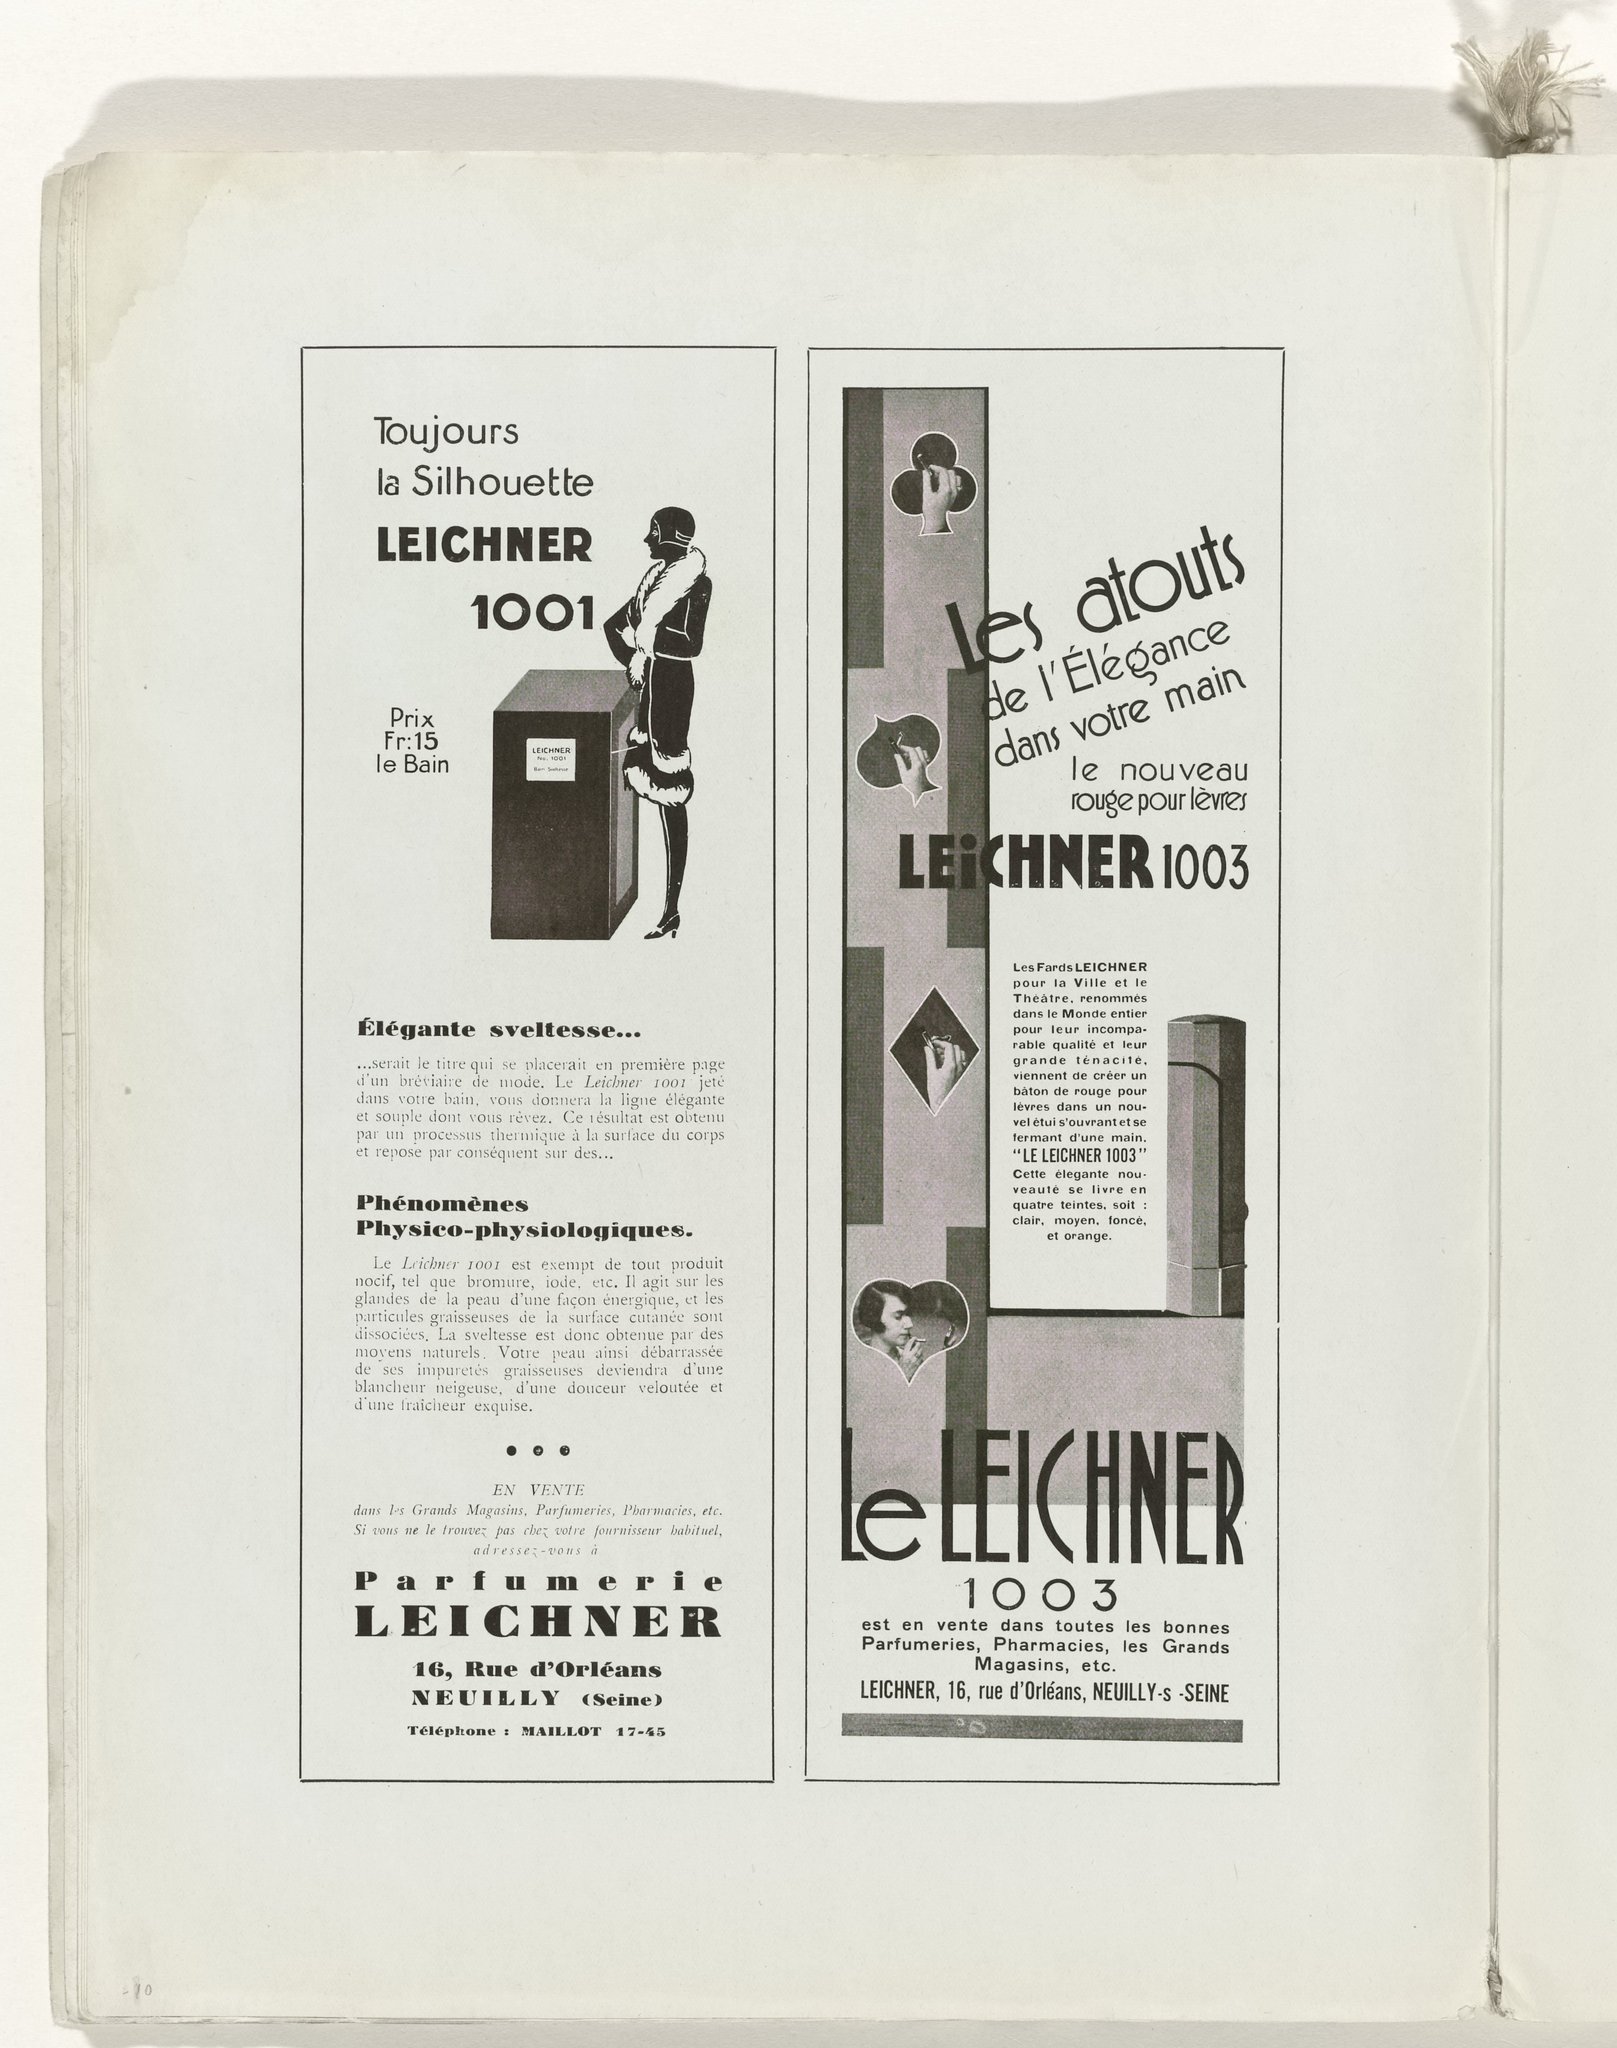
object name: fashion print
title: Art - Goût - Beauté, Feuillets de l' élégance féminine, Noël 1928, No. 100, 9e Année, p. 10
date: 1928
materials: paper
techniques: photography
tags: perfume bottle - aa - (for) women, lipstick - aa - (for) women, fashion plates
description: Twee advertenties voor parfum en lippenstift van Leichner. Pagina uit het modetijdschrift Art-Goût-Beauté (1920-1933).